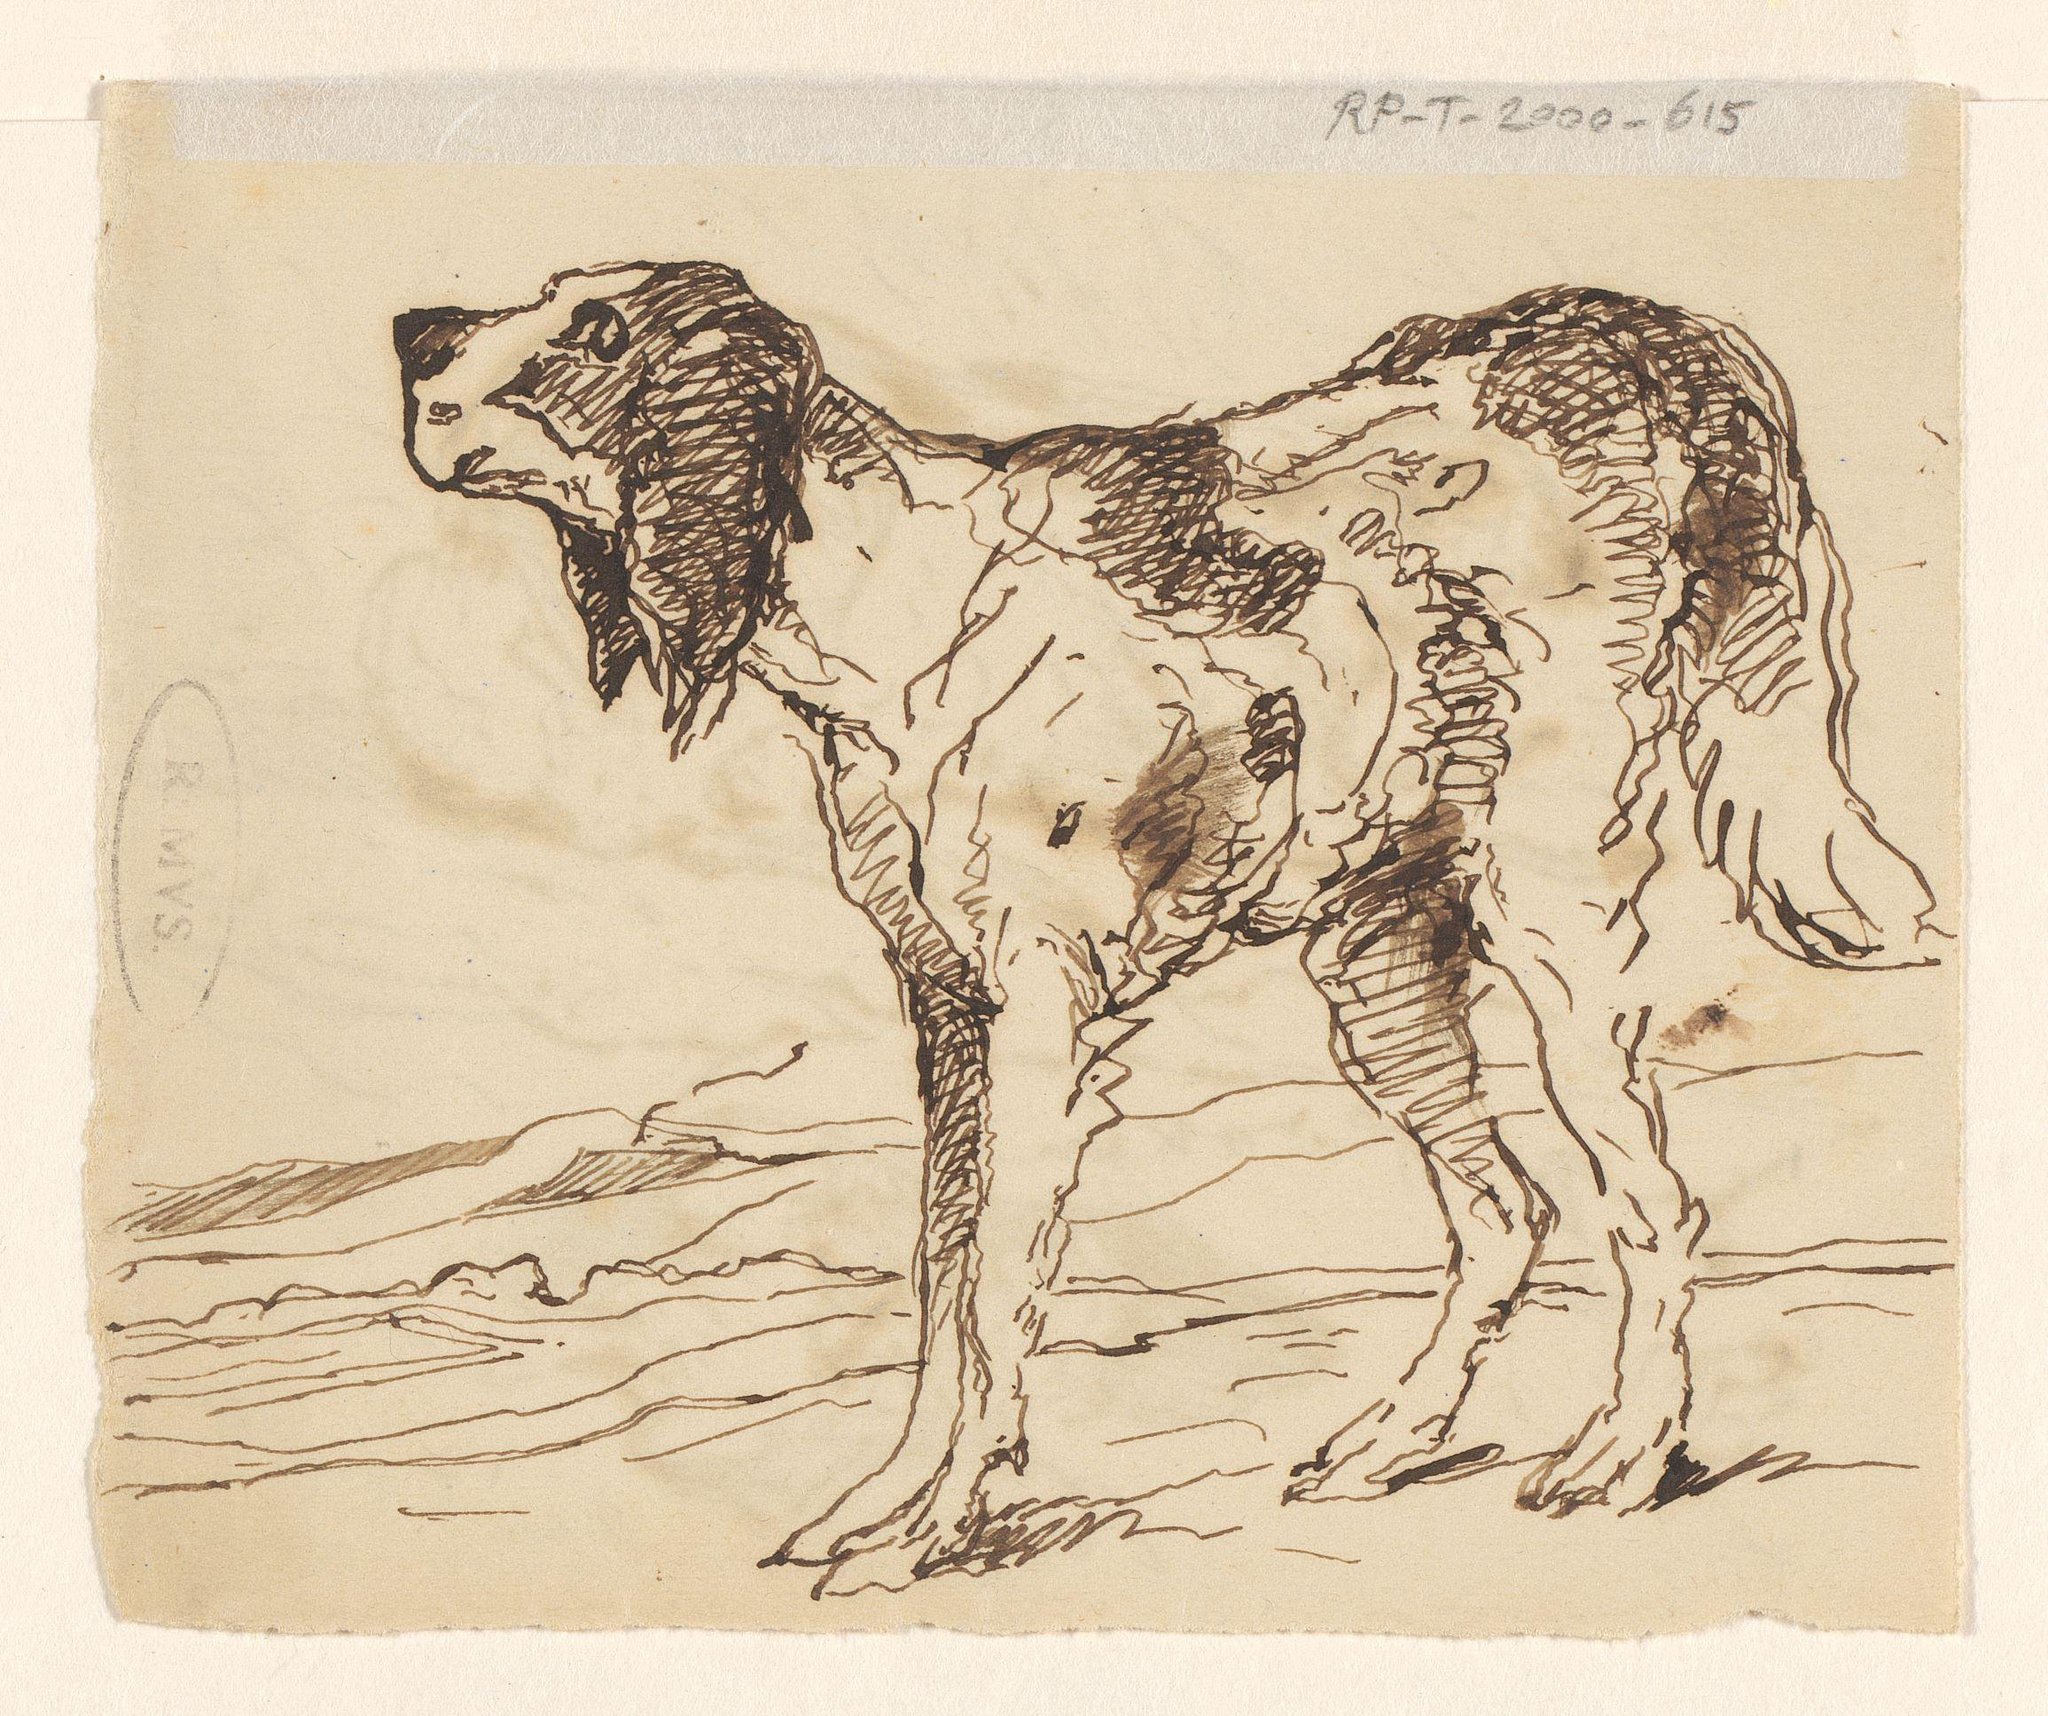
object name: drawing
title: Jachthond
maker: johannes tavenraat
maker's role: draughtsman, painter, print maker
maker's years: 1809-1881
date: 1840-1880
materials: ink, paper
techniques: pen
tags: hunting dogs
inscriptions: collector's mark: Lugt 2228, signature: ‘Tavenraat’